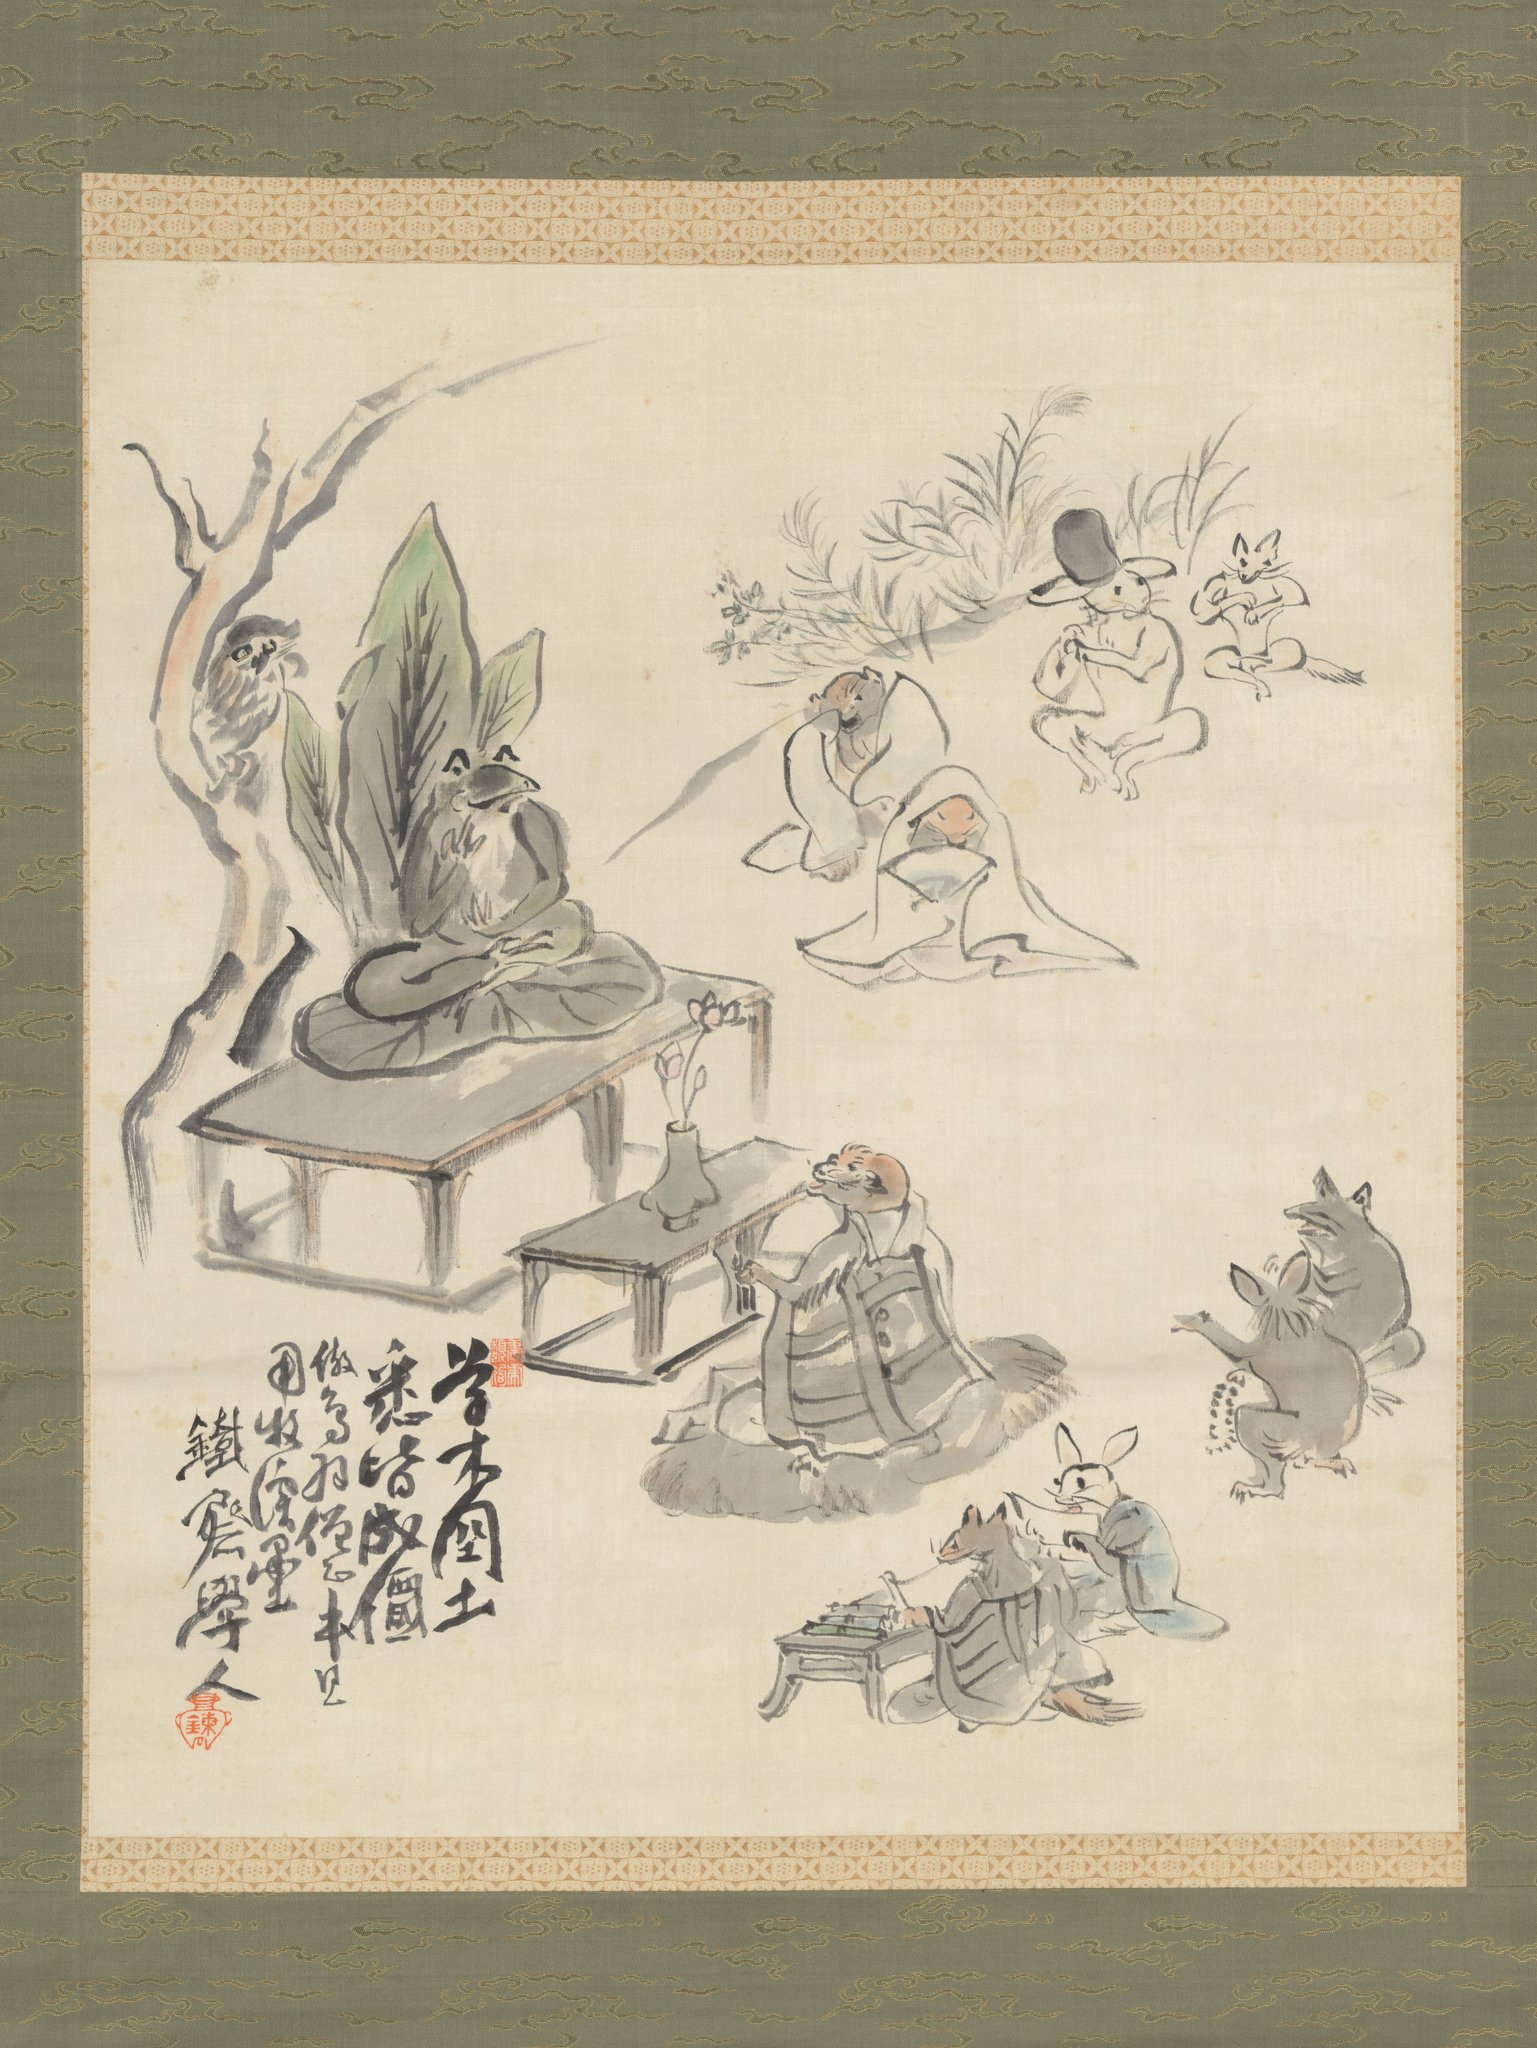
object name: hanging scroll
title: Scene Inspired by the Scrolls of Frolicking Animals and Humans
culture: japanese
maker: tomioka tessai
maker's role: artist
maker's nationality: japanese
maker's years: 1836-1924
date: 1890-1899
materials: ink, textile